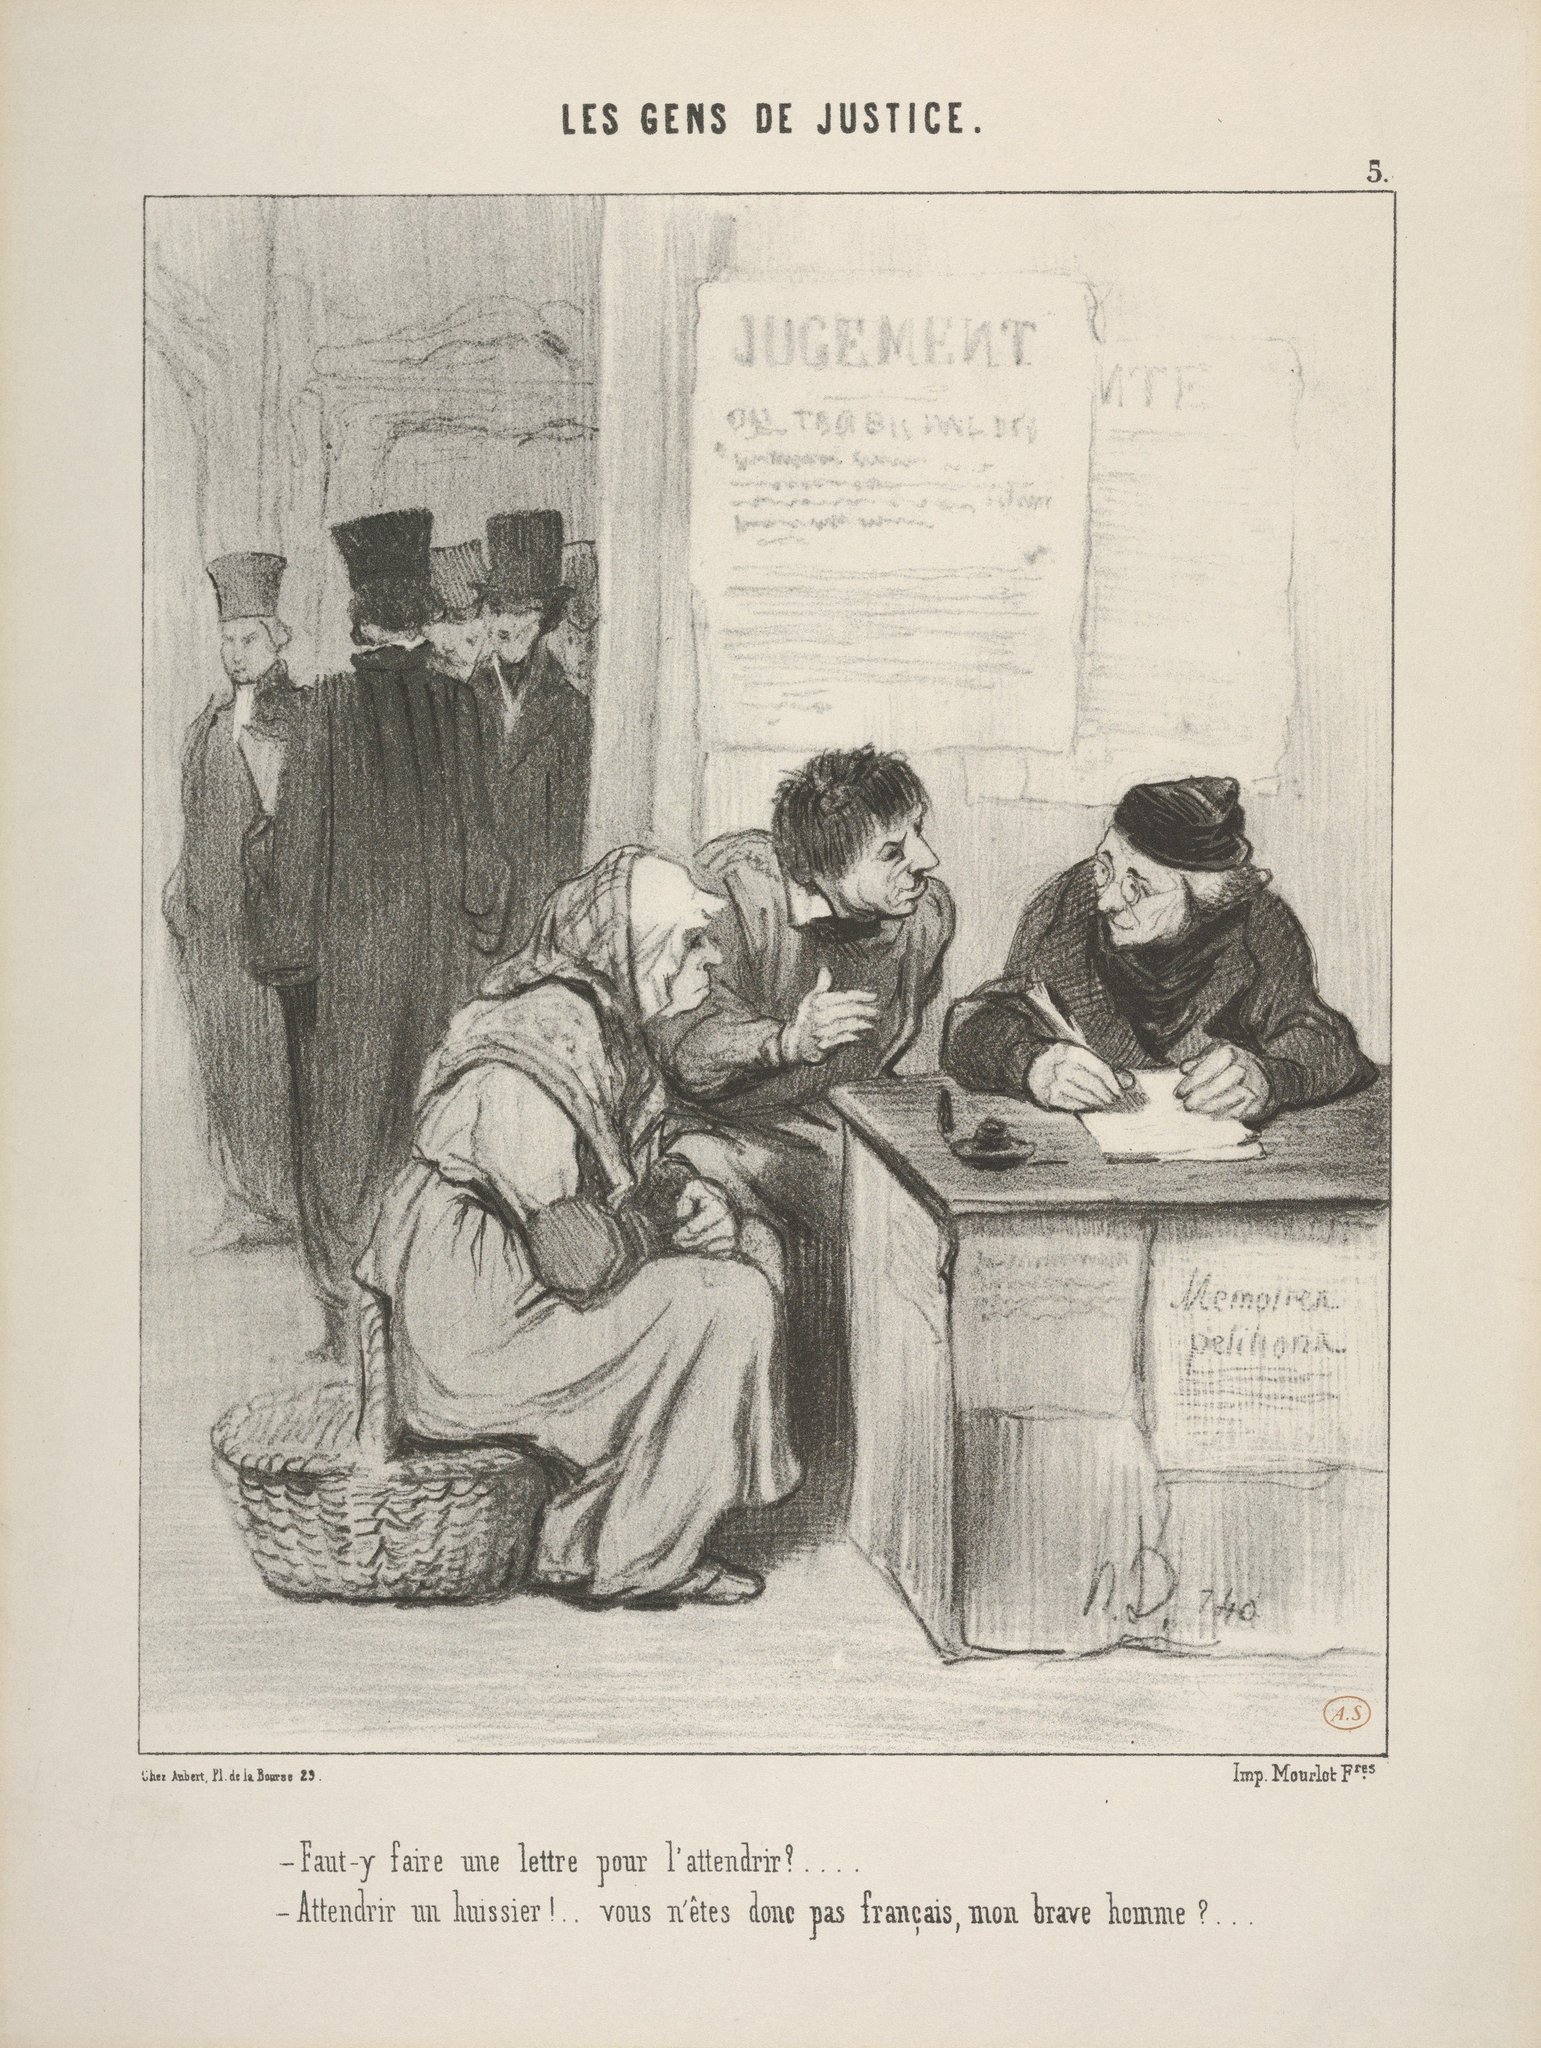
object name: print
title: "Faut-y faire une lettre pour l’attendrir?.../ Attendrir un huissier!..vous n’êtes donc pas français, mon brave homme?...." , plate 5 from Les Gens de Justice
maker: honoré daumier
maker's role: artist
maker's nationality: french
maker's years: 1808-1879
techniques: lithograph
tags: men,women,writing